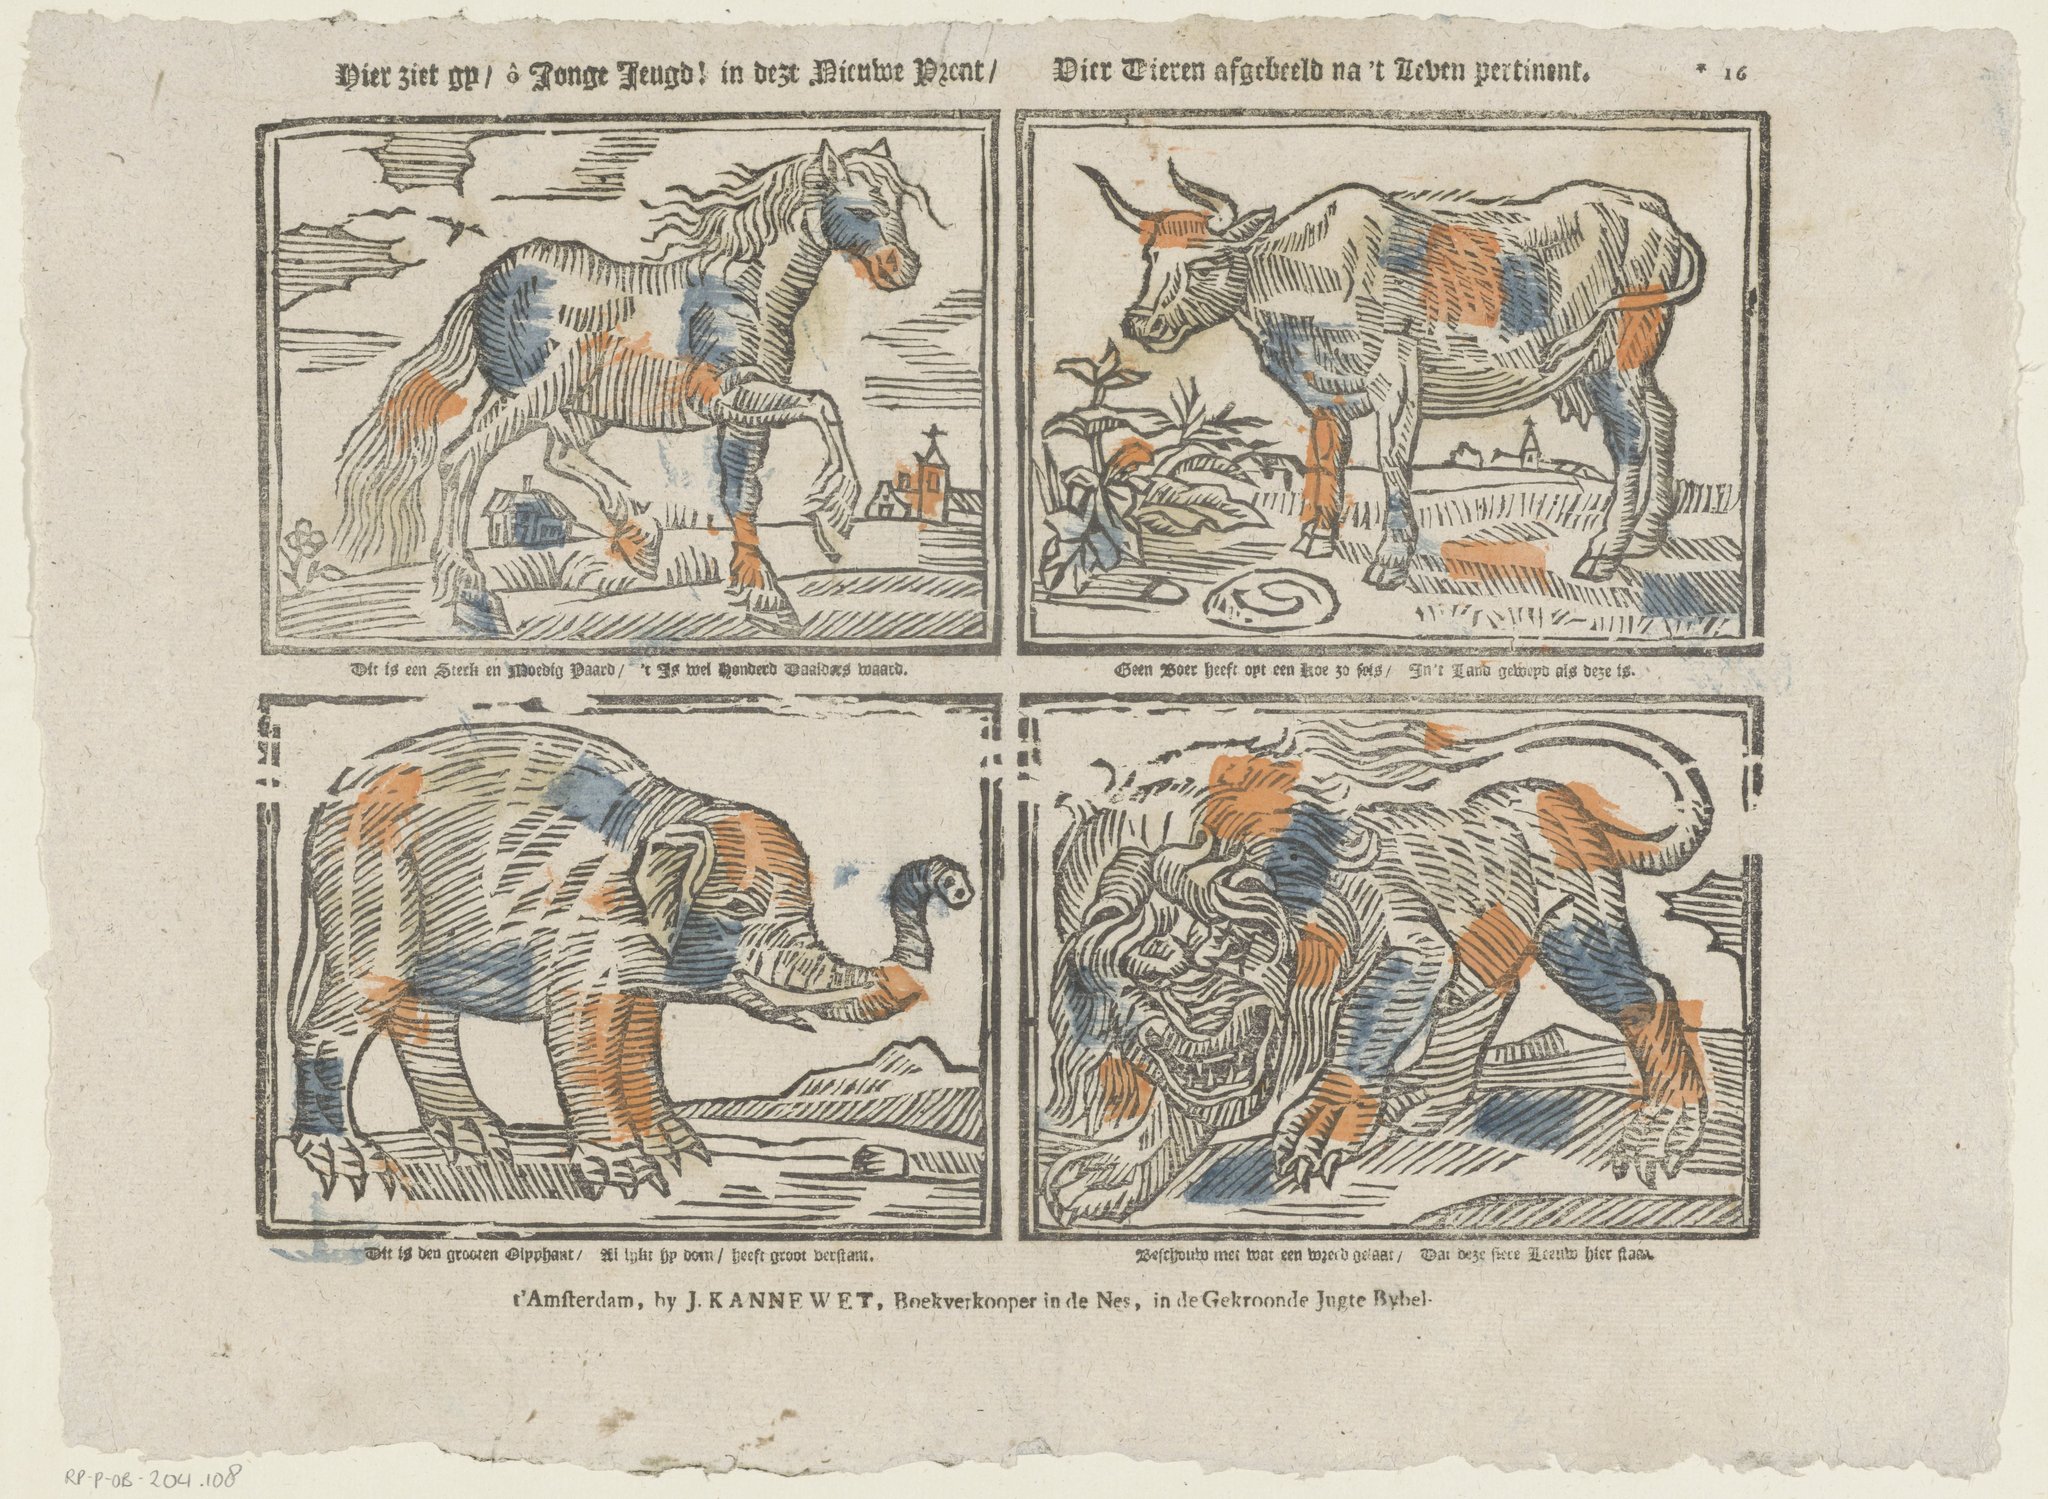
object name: print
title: Hier ziet gy / ô jonge jeugd! in deze nieuwe prent / Vier dieren afgebeeld na 't leven pertinent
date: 1725-1780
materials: paper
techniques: colour, letterpress printing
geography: amsterdam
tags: cow, animals, horse, beasts of prey, predatory animals: lion, trunked animals: elephant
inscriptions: collector's mark: Lugt 2760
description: Blad met 4 voorstellingen van een paard, een koe, een olifant en een leeuw. Onder elke afbeelding een onderschrift. Genummerd rechtsboven: *16.